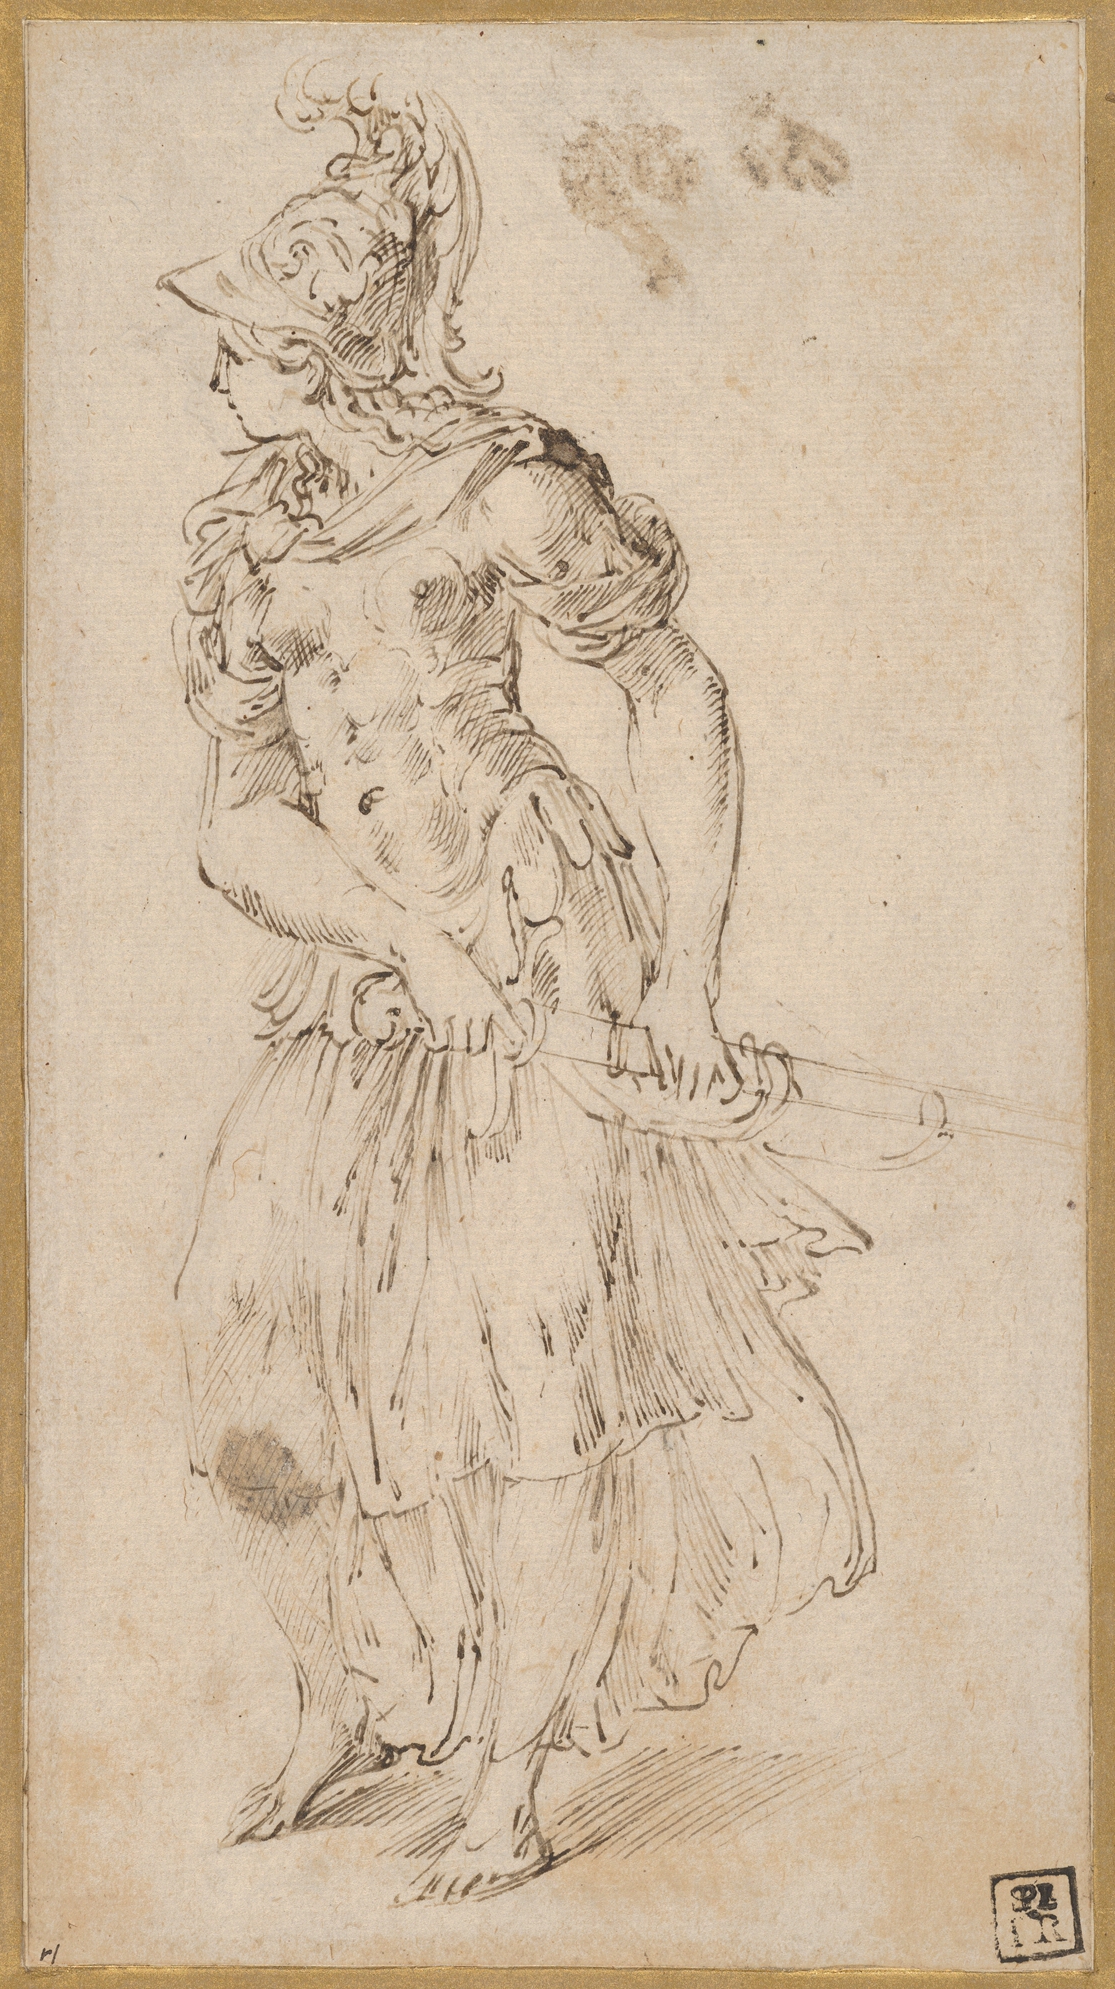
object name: drawing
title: Standing Female Figure in Armor Drawing Her Sword (Minerva or Bellona)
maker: parmigianino (girolamo francesco maria mazzola)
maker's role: artist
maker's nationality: italian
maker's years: 1503-1540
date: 1535-1538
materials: chalk, ink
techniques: pen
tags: armor,swords,women